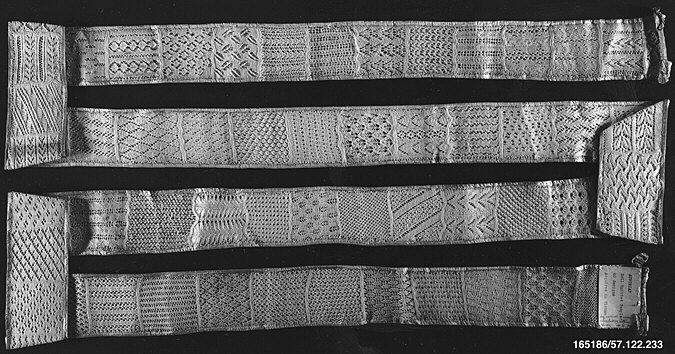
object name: sampler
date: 1801-1900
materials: wool